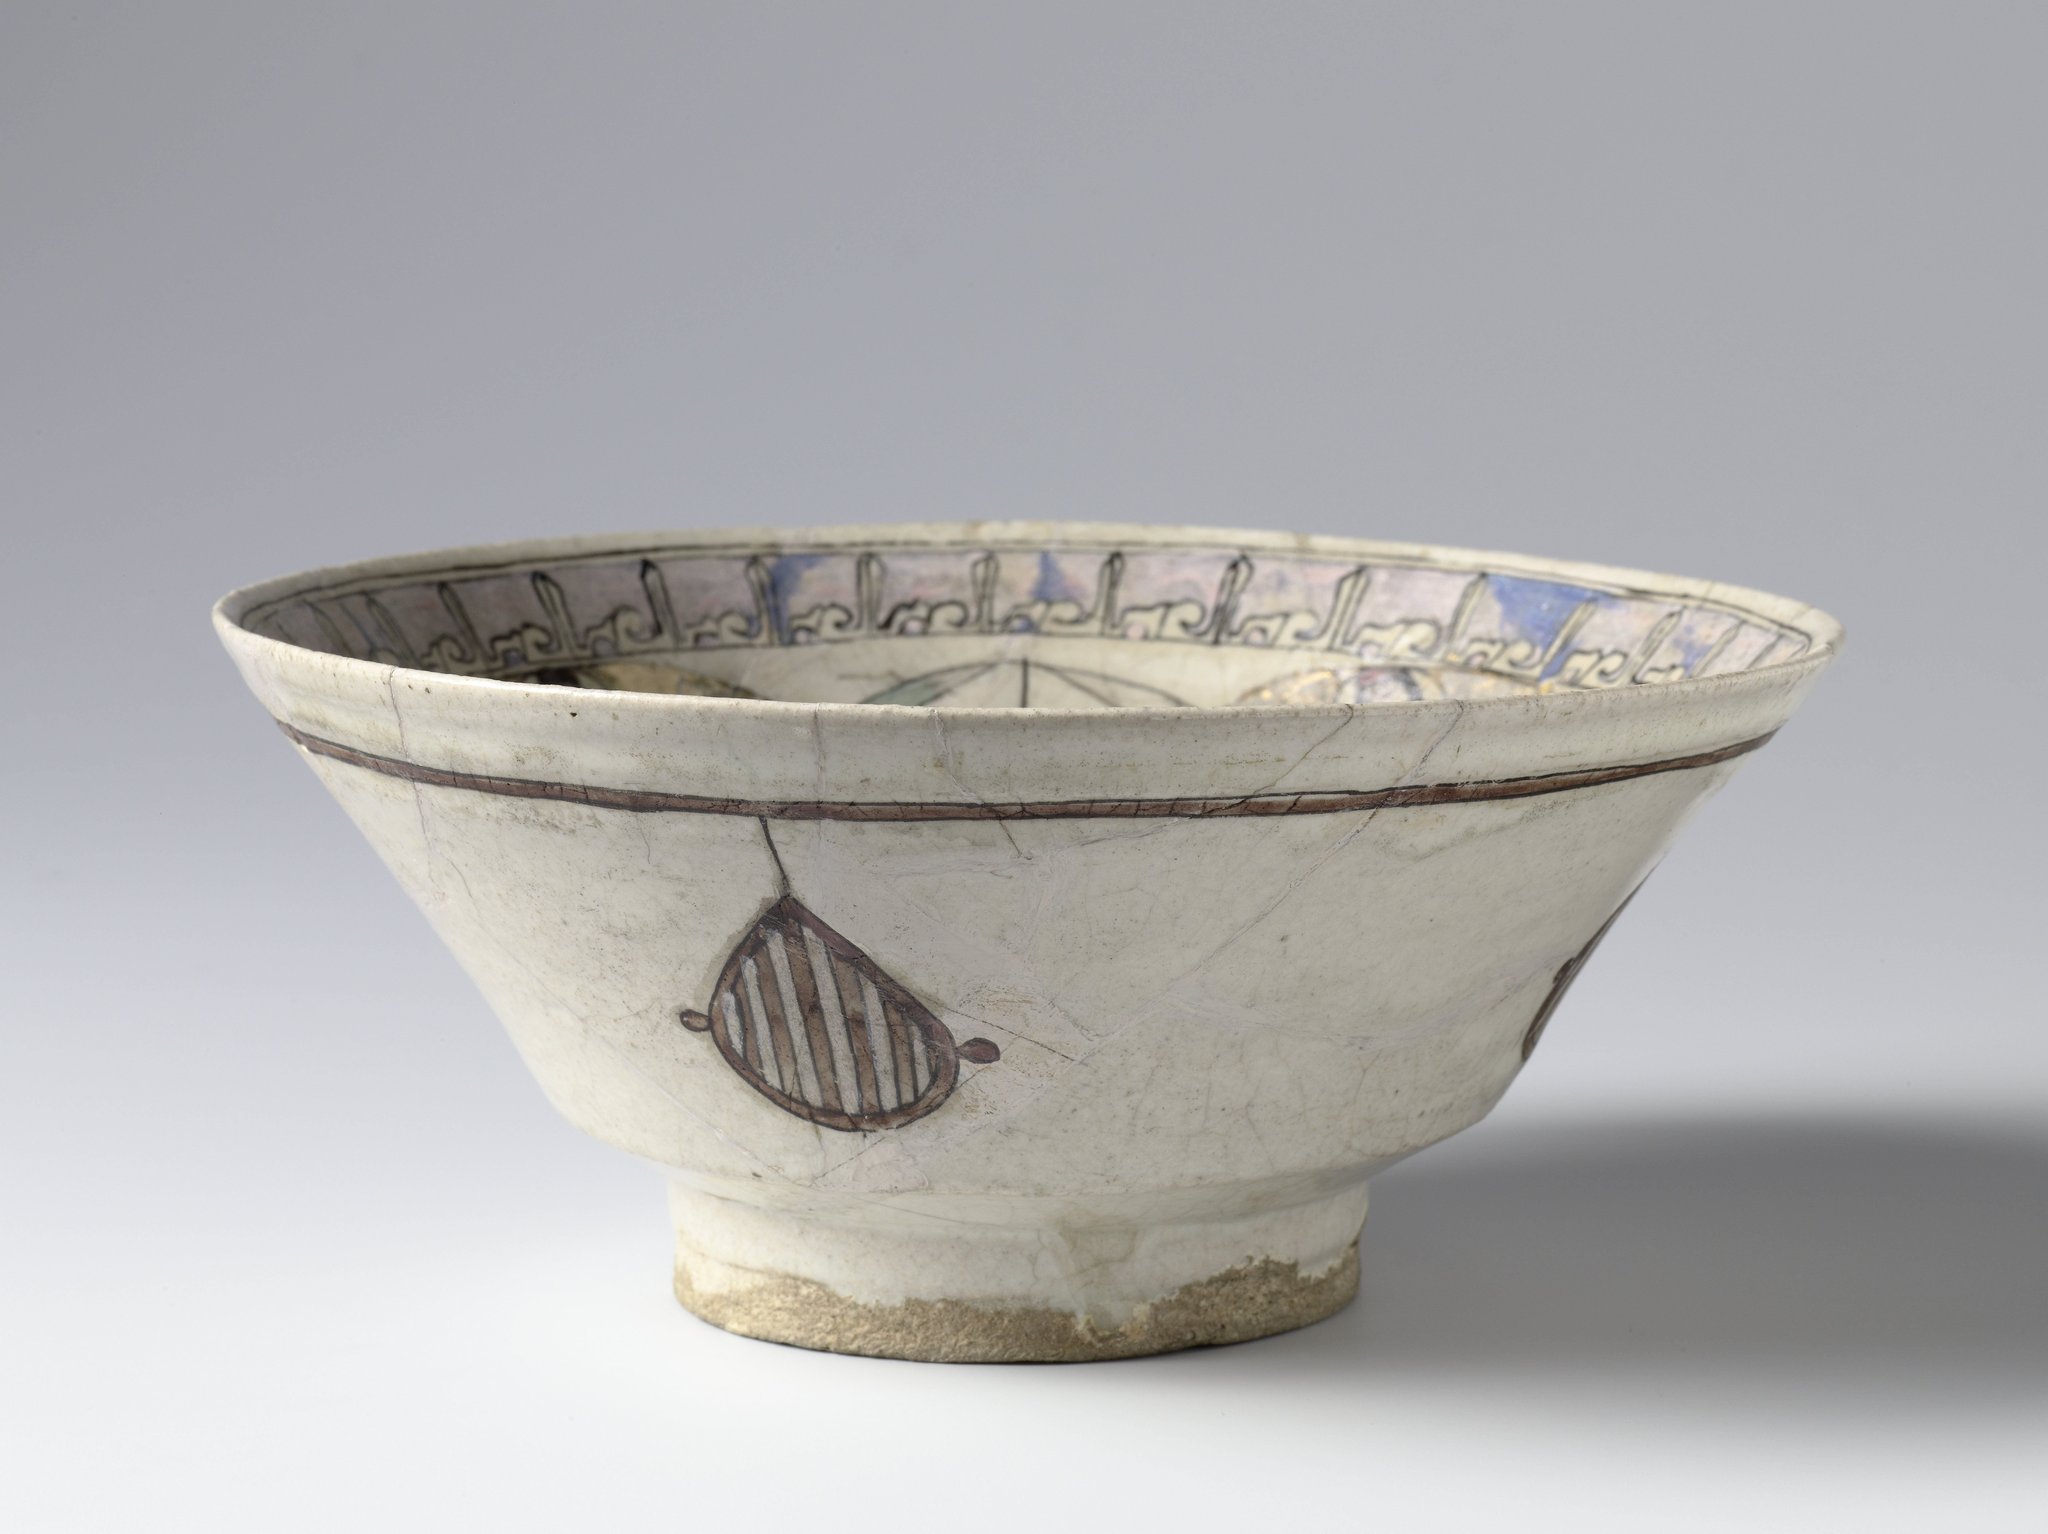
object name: bowl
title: Bowl with horsemen in medallions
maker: Anonymous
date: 1175-1224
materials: earthenware, glaze, gold, paint, quartz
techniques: firing, turning, vitrification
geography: kashan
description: Kom van kwarts-fritgoed met een polychrome decoratie. Op de bodem een ruiter in een medaillon. De binnenwand met vier ovale cartouches met ruiters, verbonden door een druppelvormig medaillon.